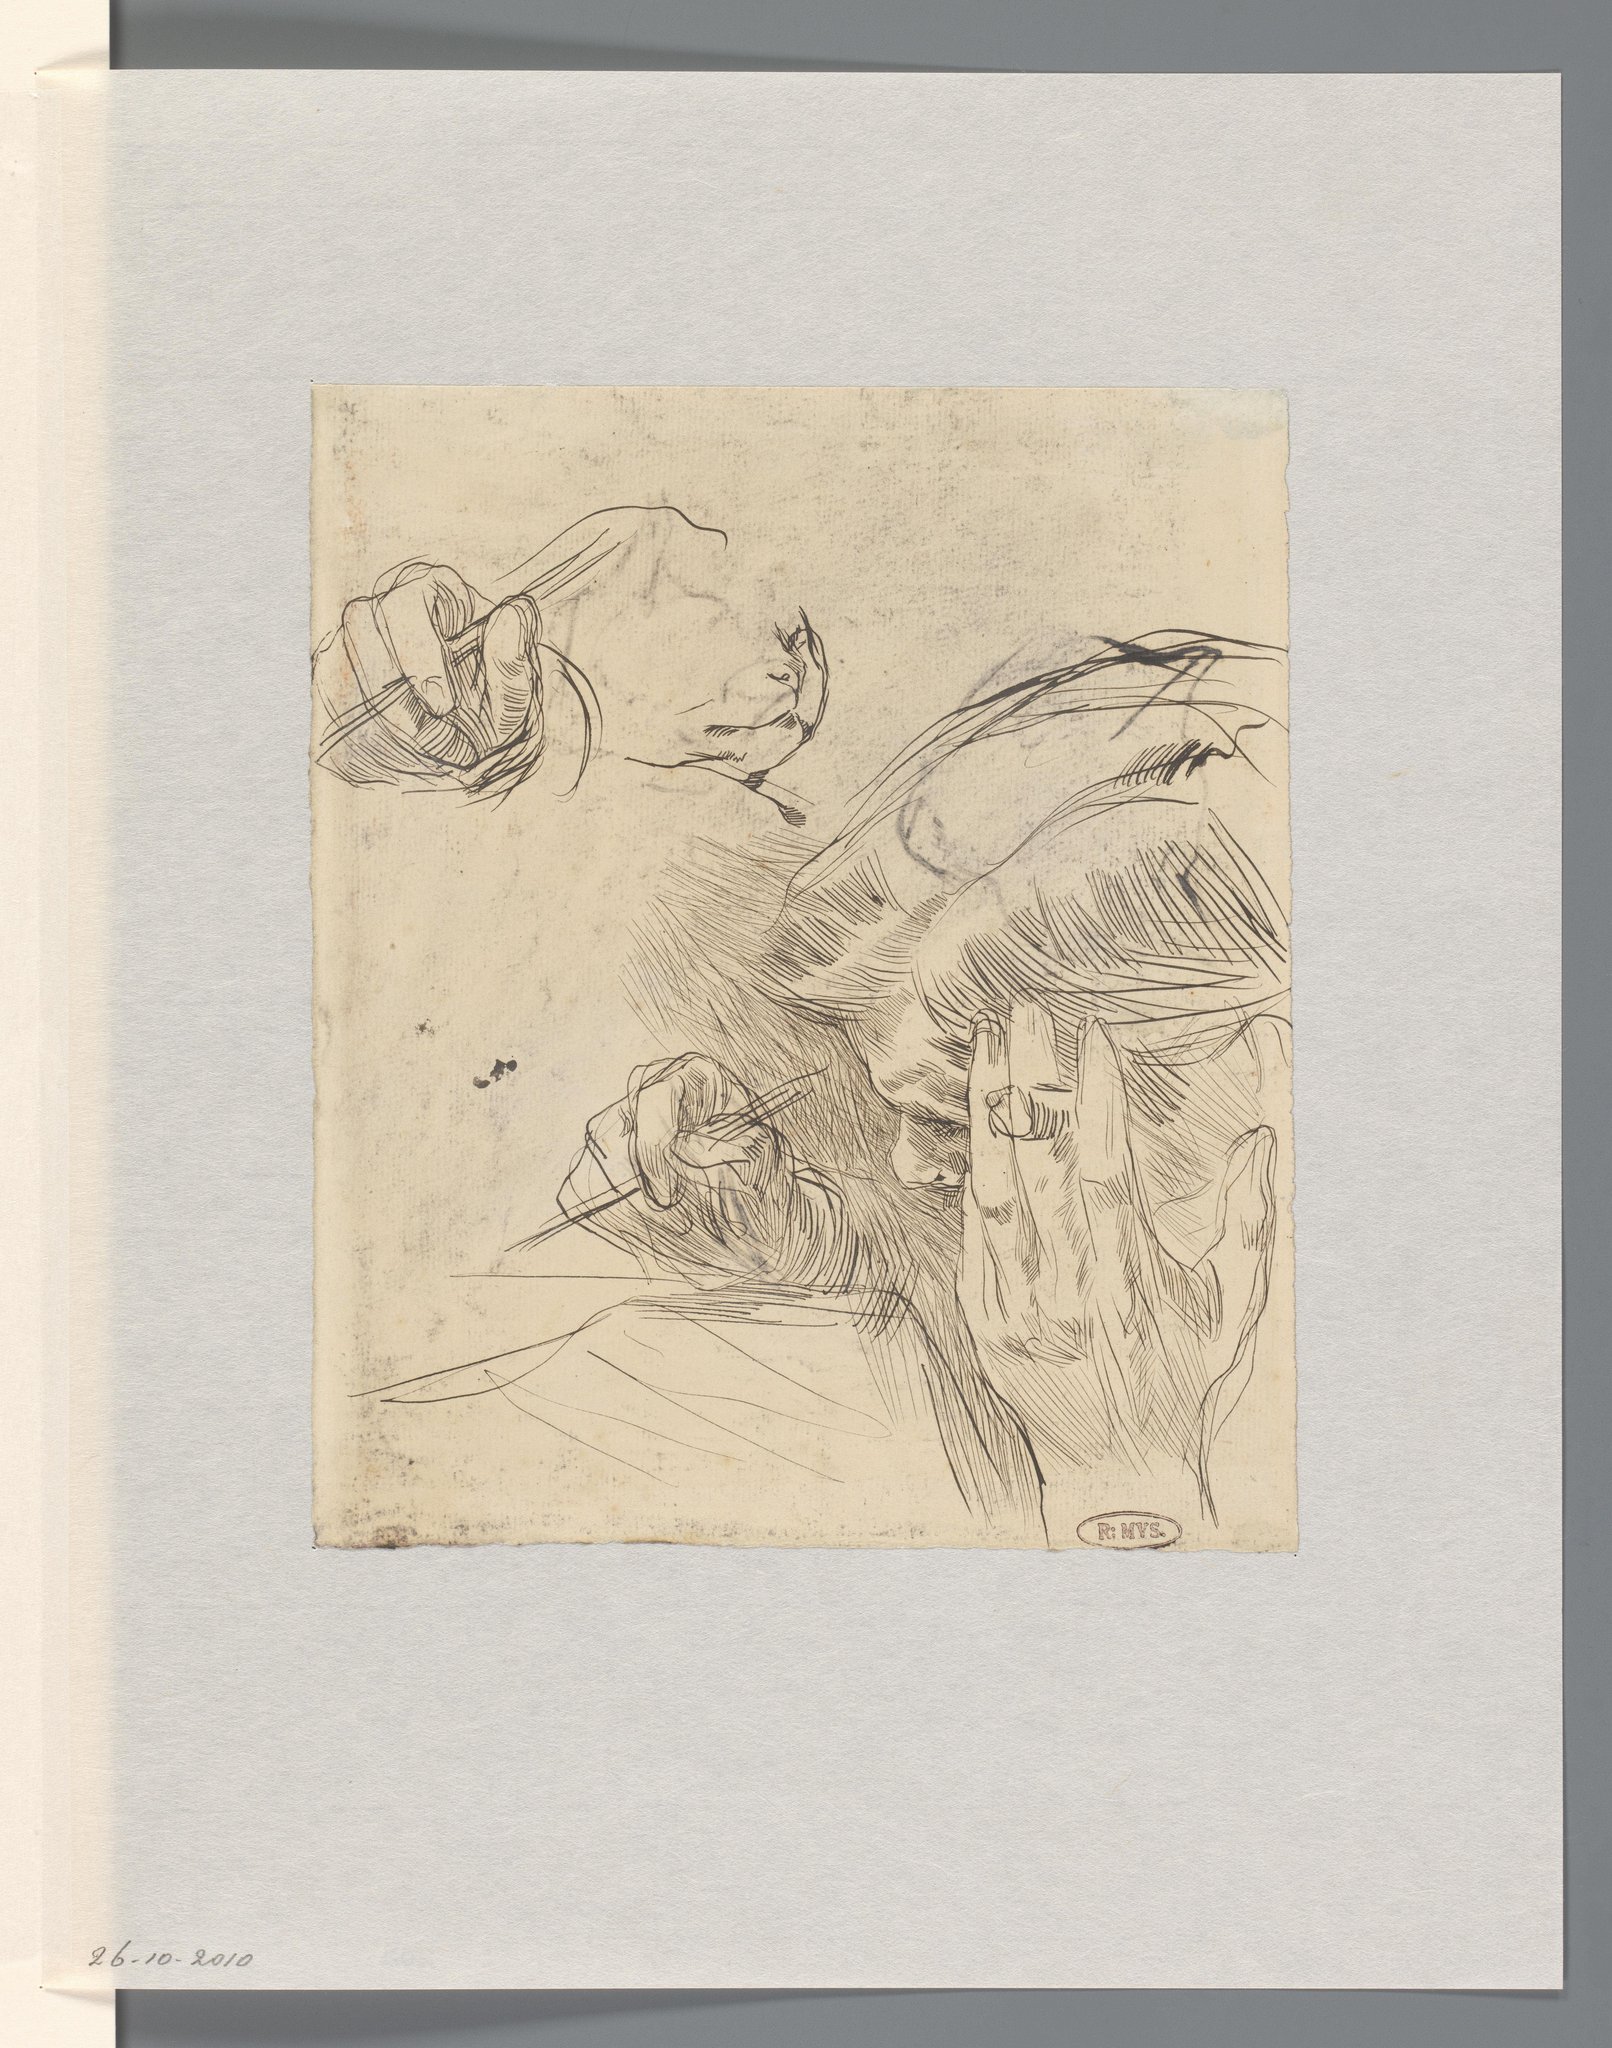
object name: drawing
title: Frederik van Eeden, schrijvend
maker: jan veth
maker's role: designer, draughtsman, painter, print maker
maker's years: 1864-1925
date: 1874-1925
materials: ink, paper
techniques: pen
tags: haarlem, frederik van eeden, handwriting, writing as activity, historical persons